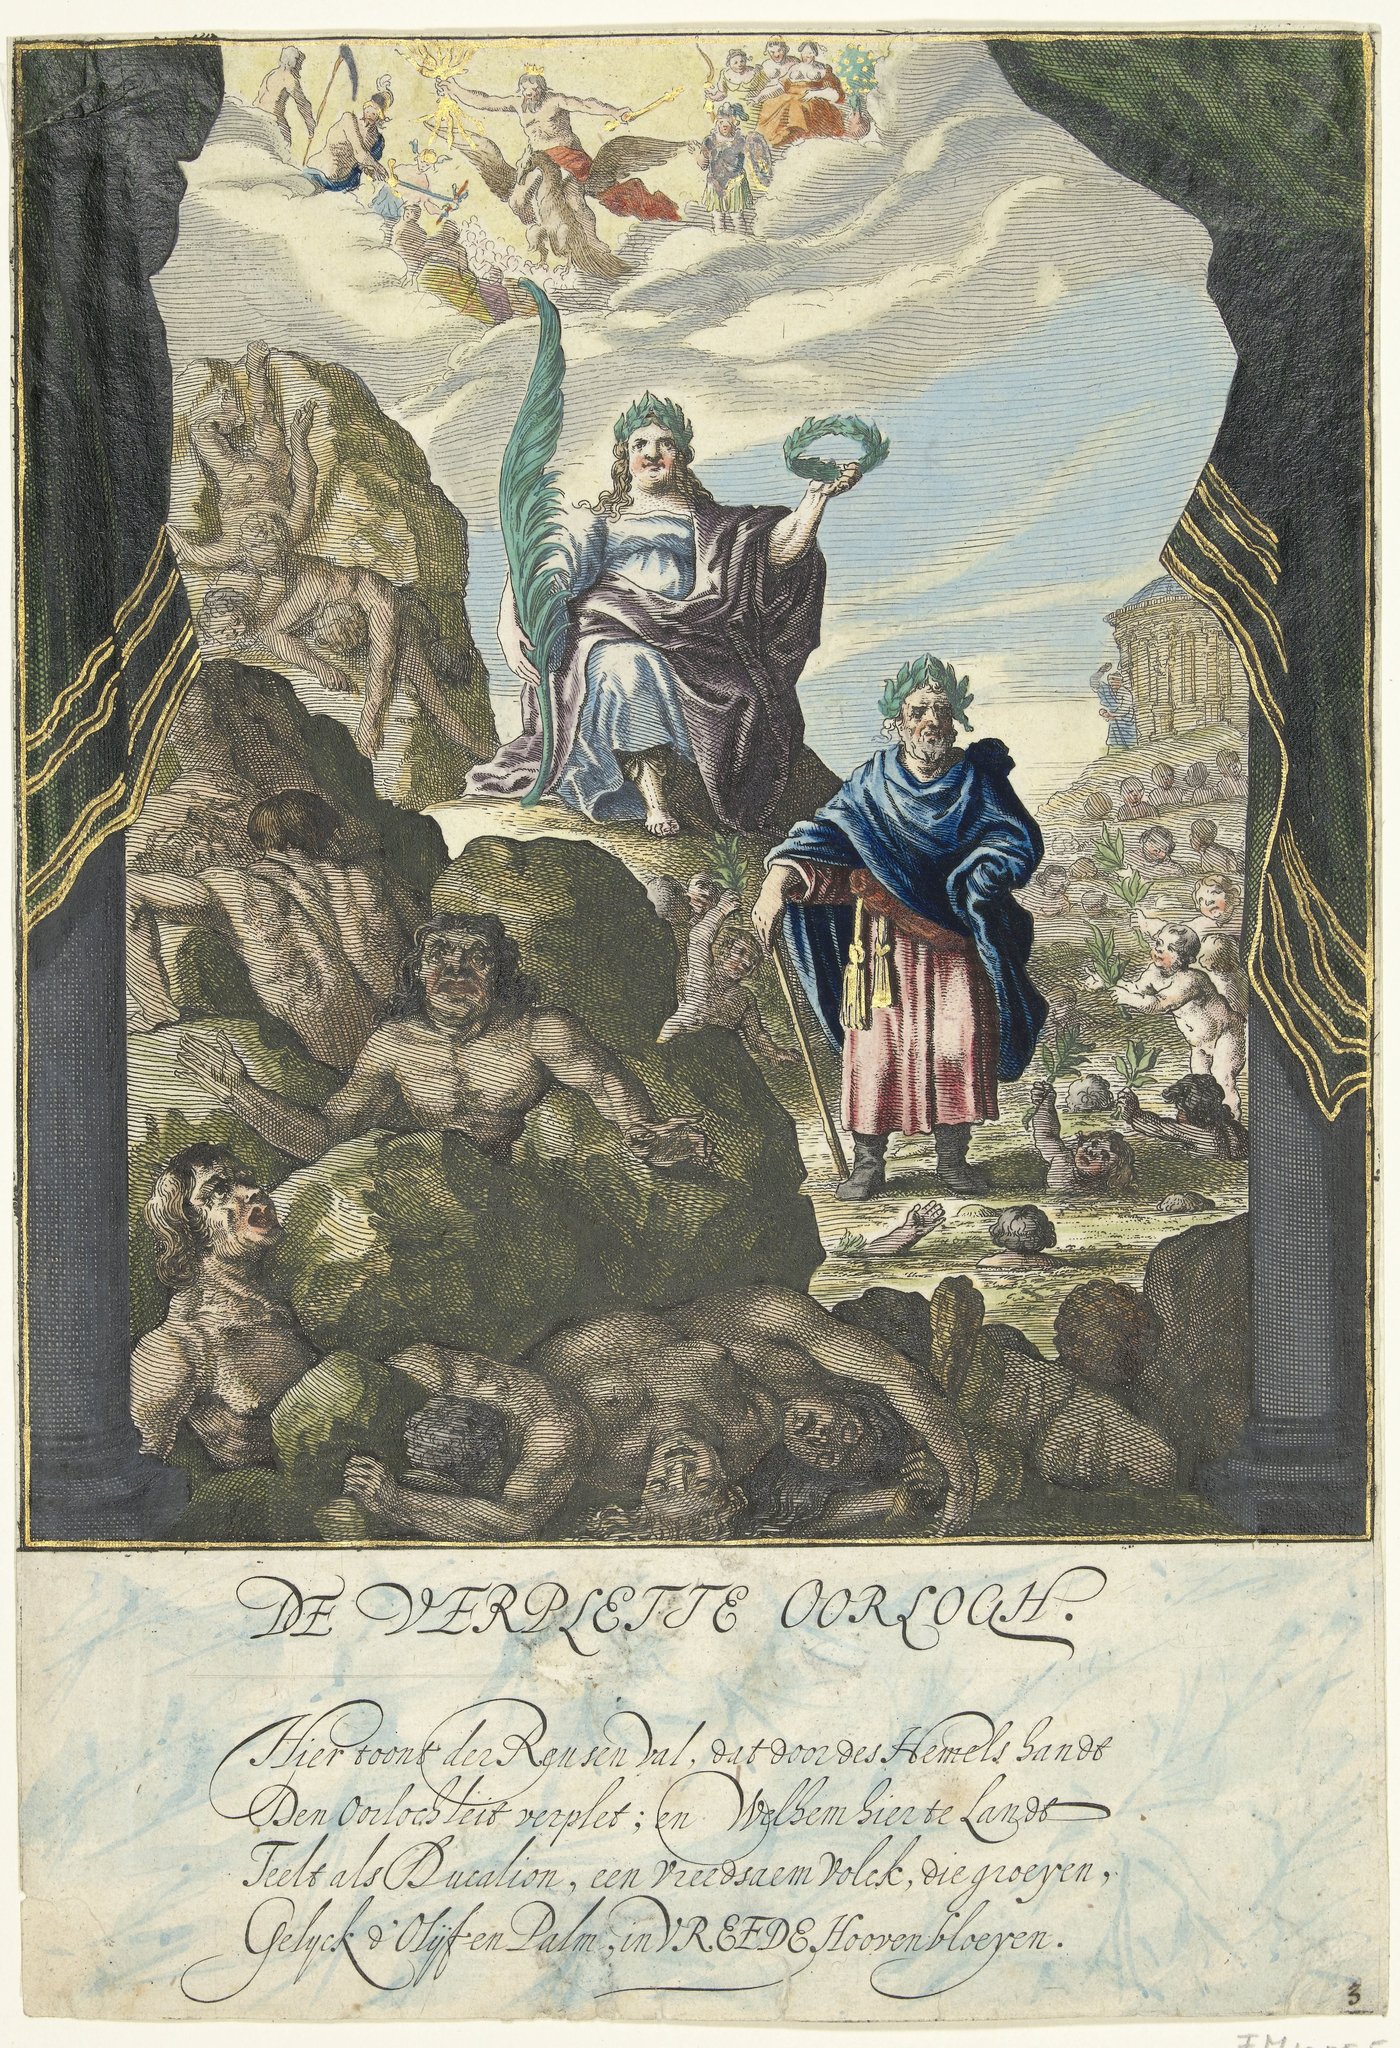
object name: print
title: Vertoning van het Verpletteren van de Oorlog, 1648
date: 1649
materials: paper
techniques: etching, hand coloring, lacquer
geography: amsterdam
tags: symbols, allegories of peace, 'pax'; 'pace' (ripa), theatre, theatrical performance, festivities on events of national importance, stones turning into men: stones thrown by deucalion and pyrrha, as directed by the oracle of themis, turn into men (ovid, metamorphoses x 400), the giants buried beneath volcanoes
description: Vertoning van het Verpletteren van de Oorlog. Onderdeel van de vertoningen opgevoerd op 23 juni 1648 op de Schouwburg te Amsterdam naar aanleiding van het sluiten van de Vrede van Munster. De vijfde voorstelling toont hoe de Oorlog onder een stapel rotsblokken wordt verpletterd. Deucalion en Vrede zien toe. In het onderschrift een vers van 4 regels in het Nederlands. Genummerd met pen rechtsonder: 3.